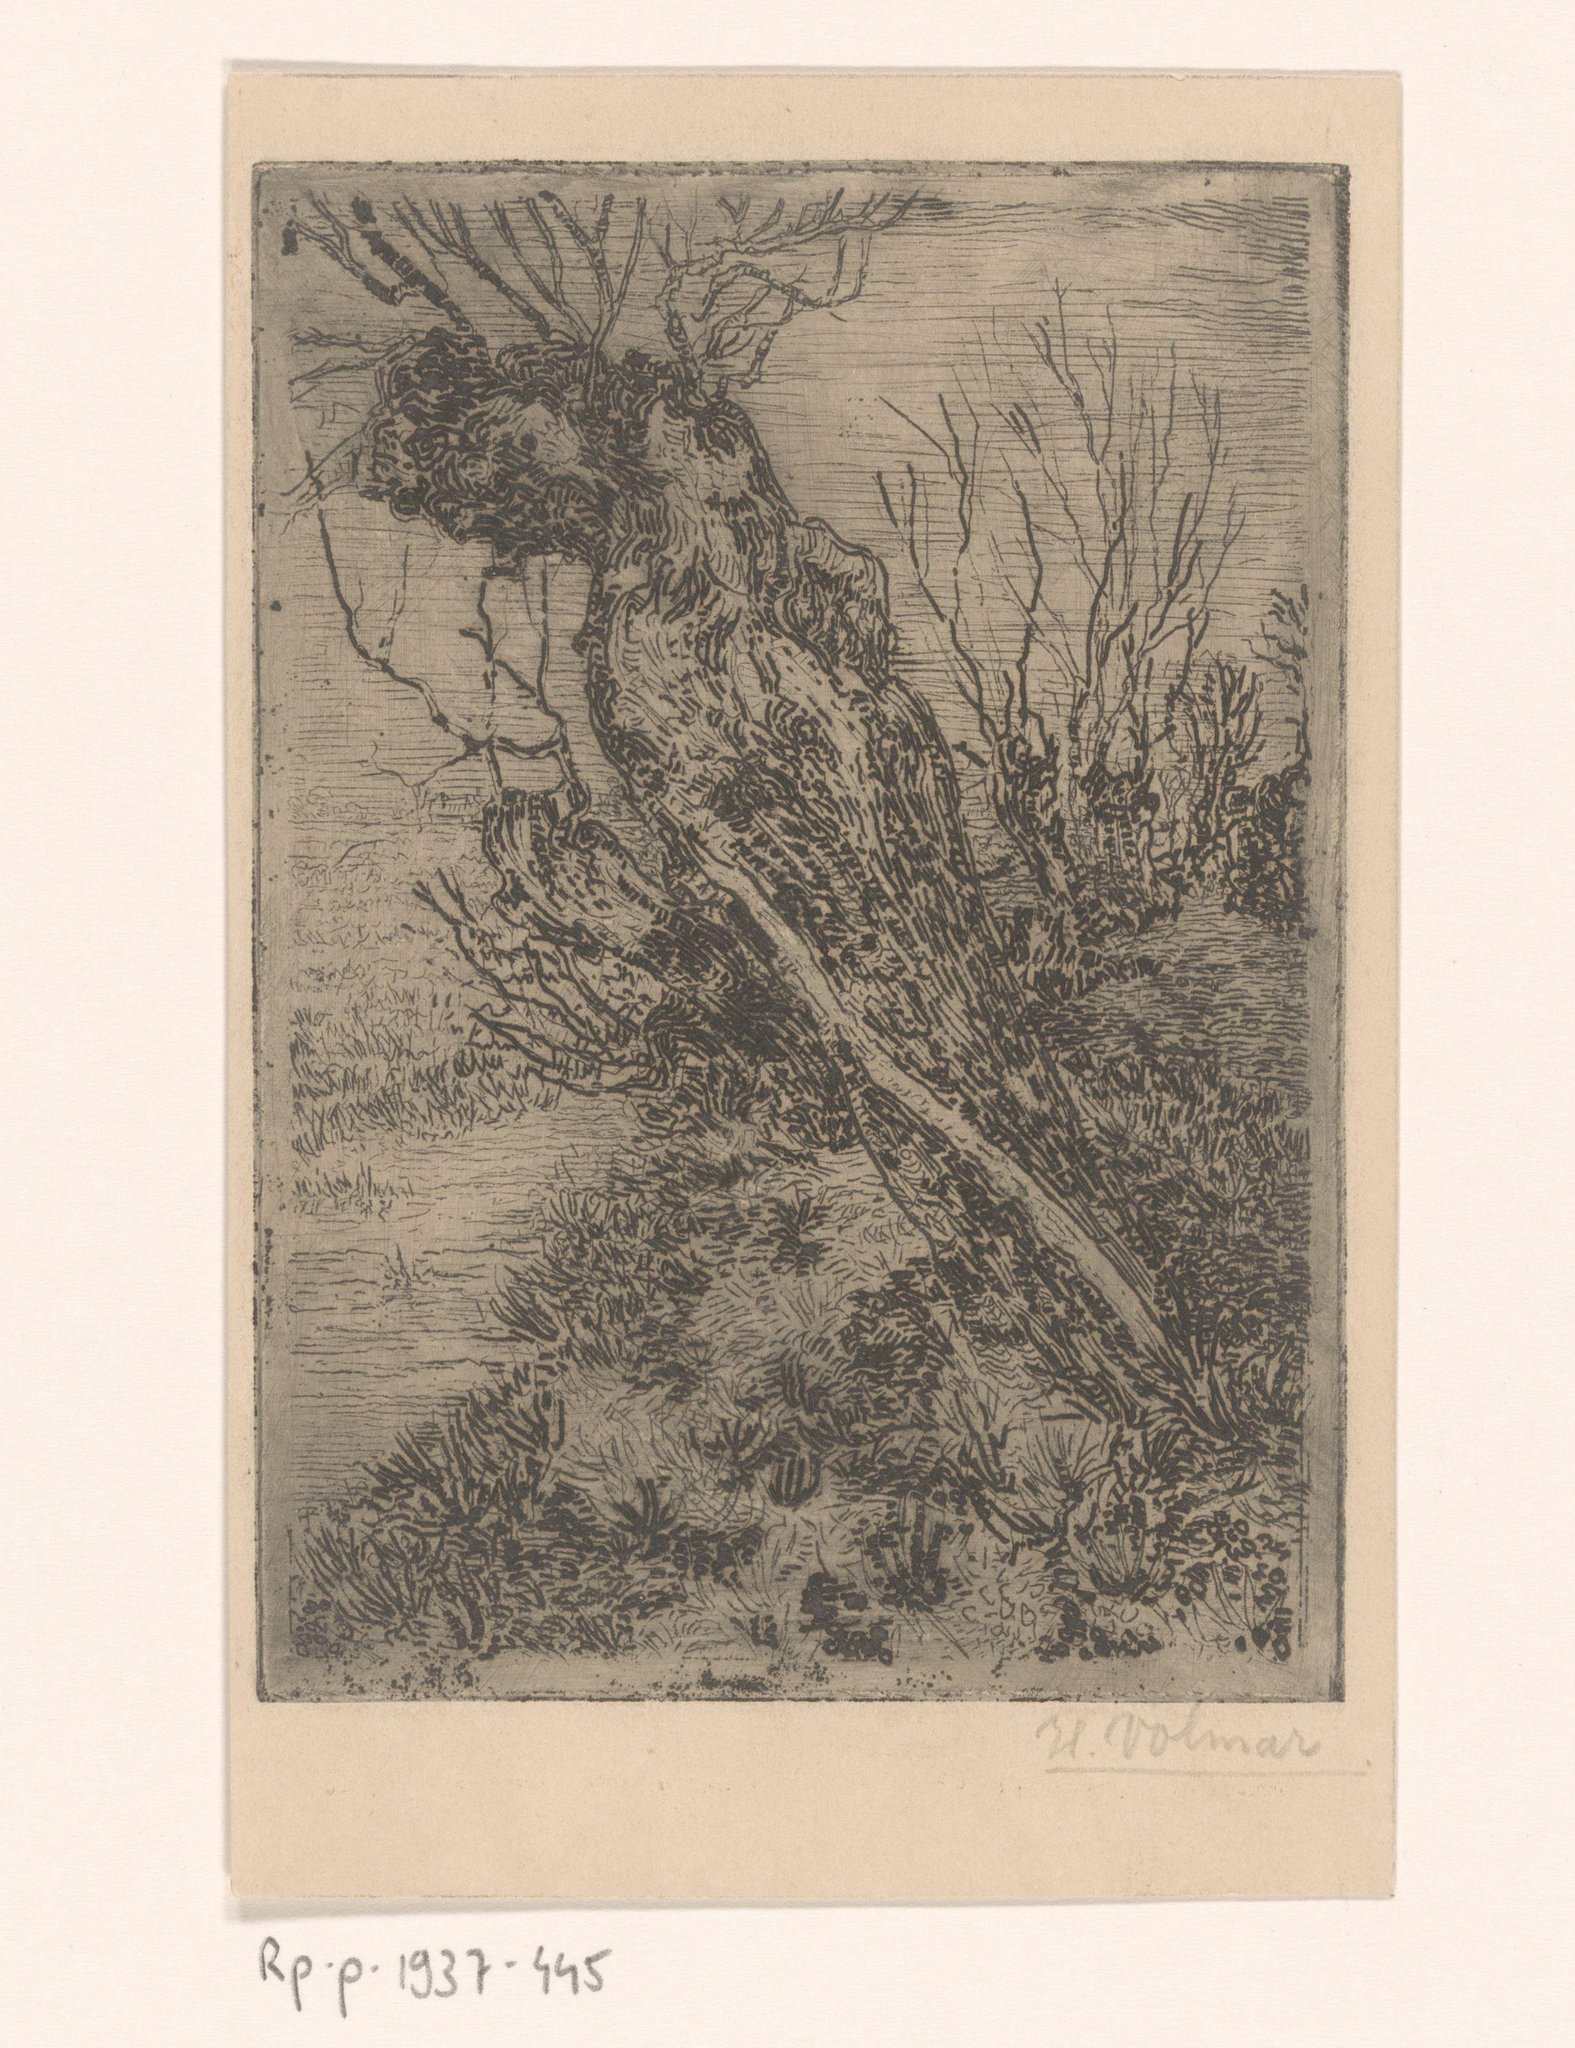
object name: print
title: Knotwilg bij het water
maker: hendrik w.n. volmar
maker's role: print maker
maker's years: 1881-1921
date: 1891-1921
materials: paper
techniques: etching, intaglio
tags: trees: willow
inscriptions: collector's mark: Lugt 2228, collector's mark: Lugt 2760